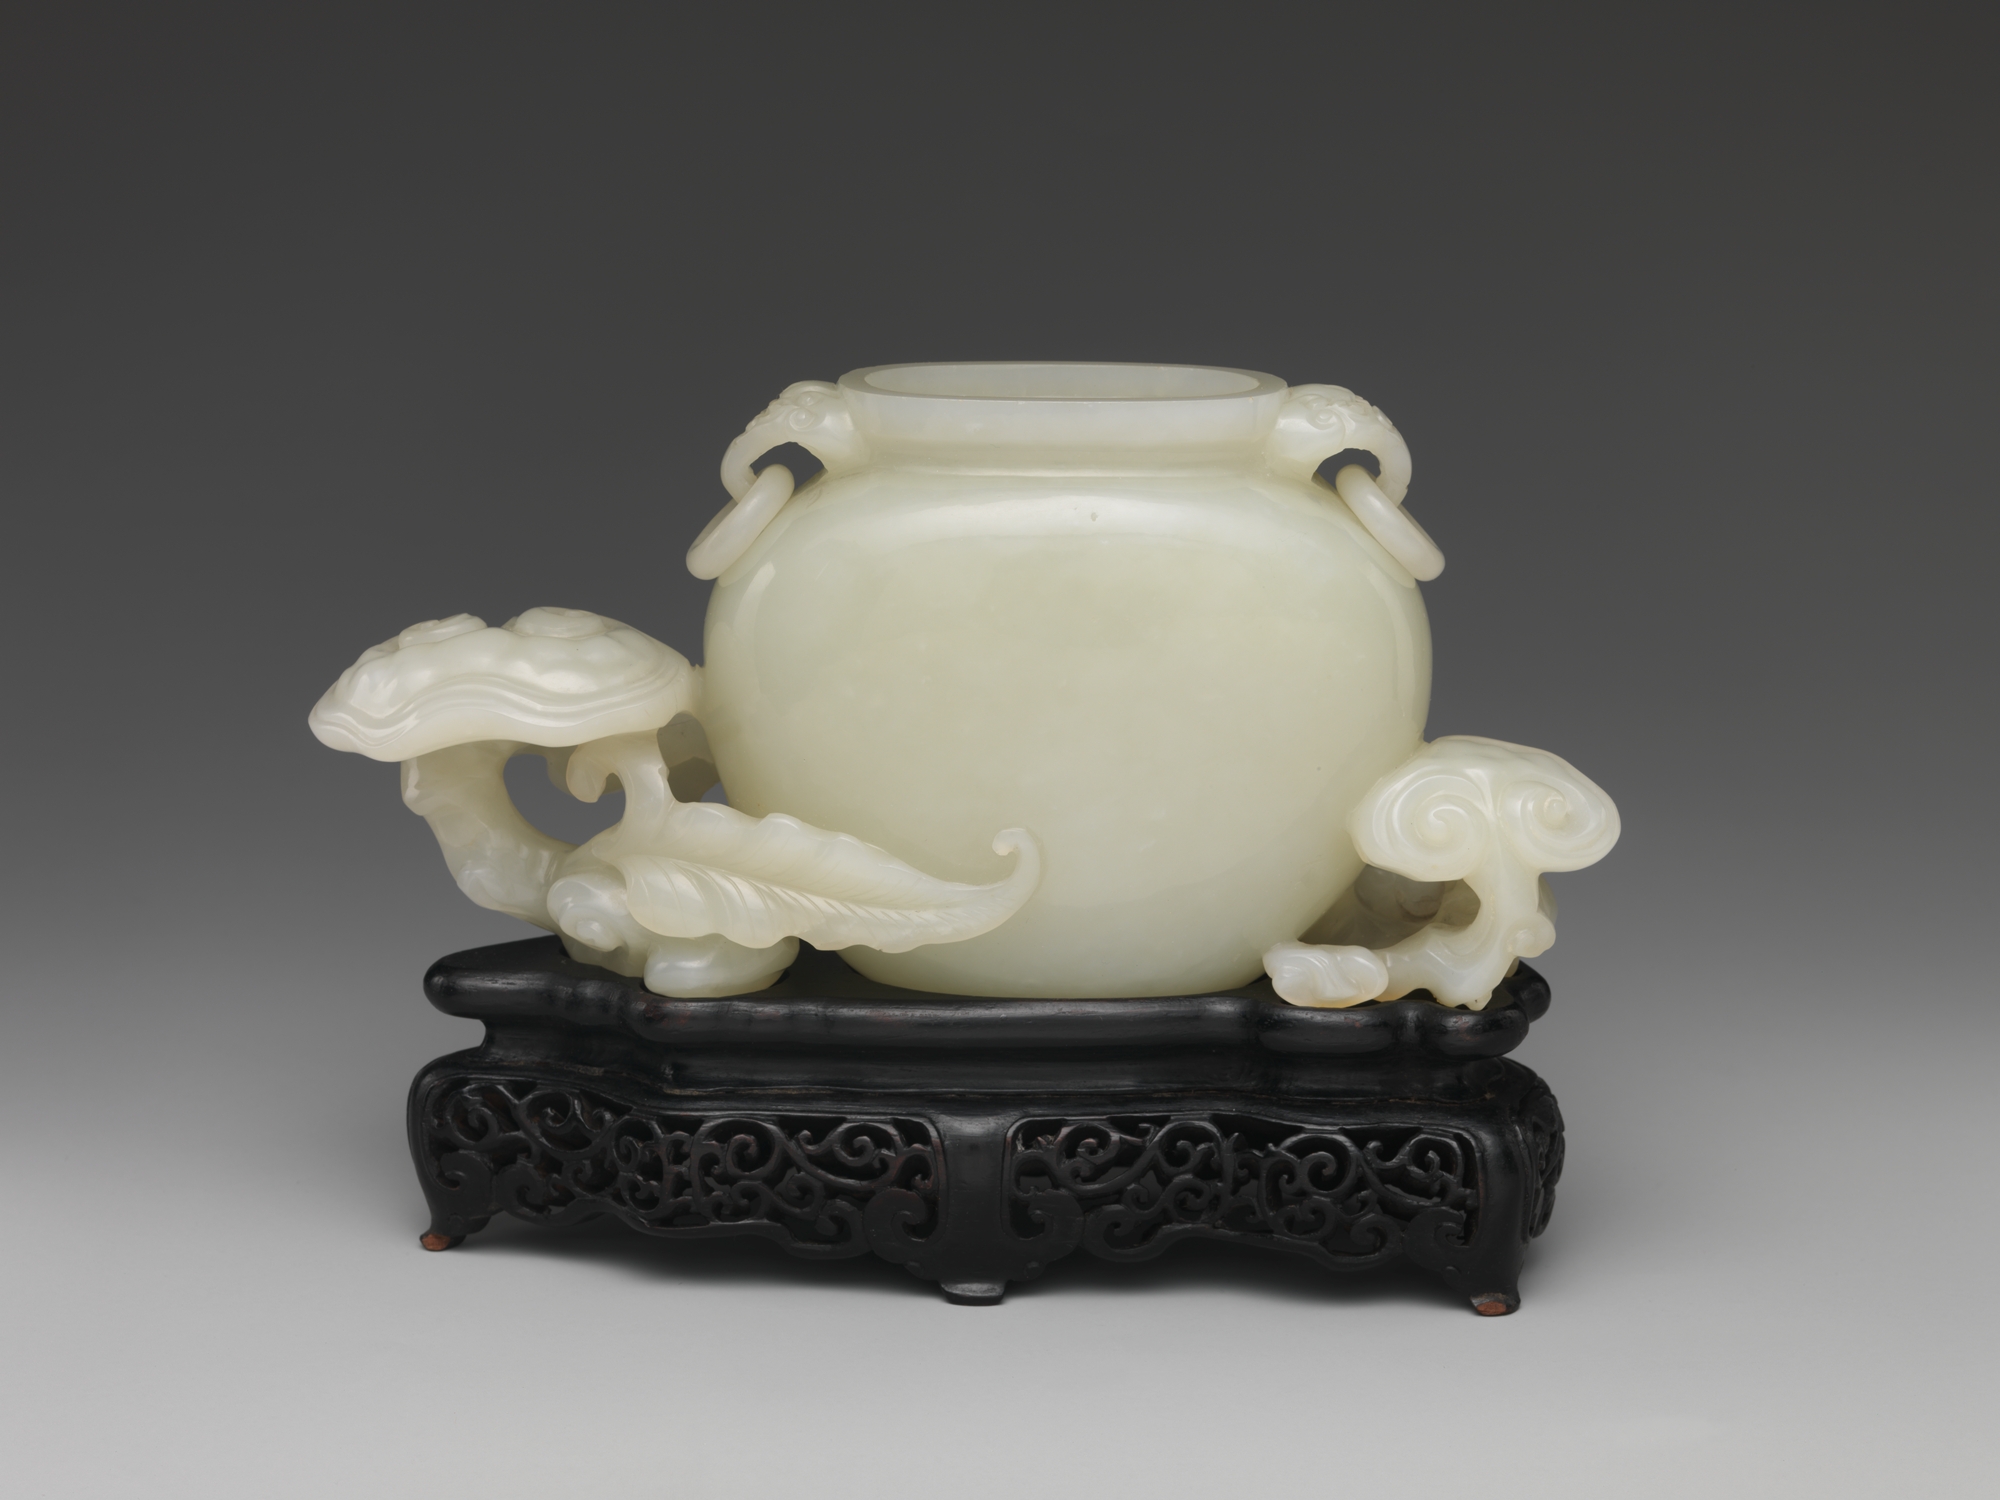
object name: water jar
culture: chinese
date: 1644-1911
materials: jade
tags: leaves